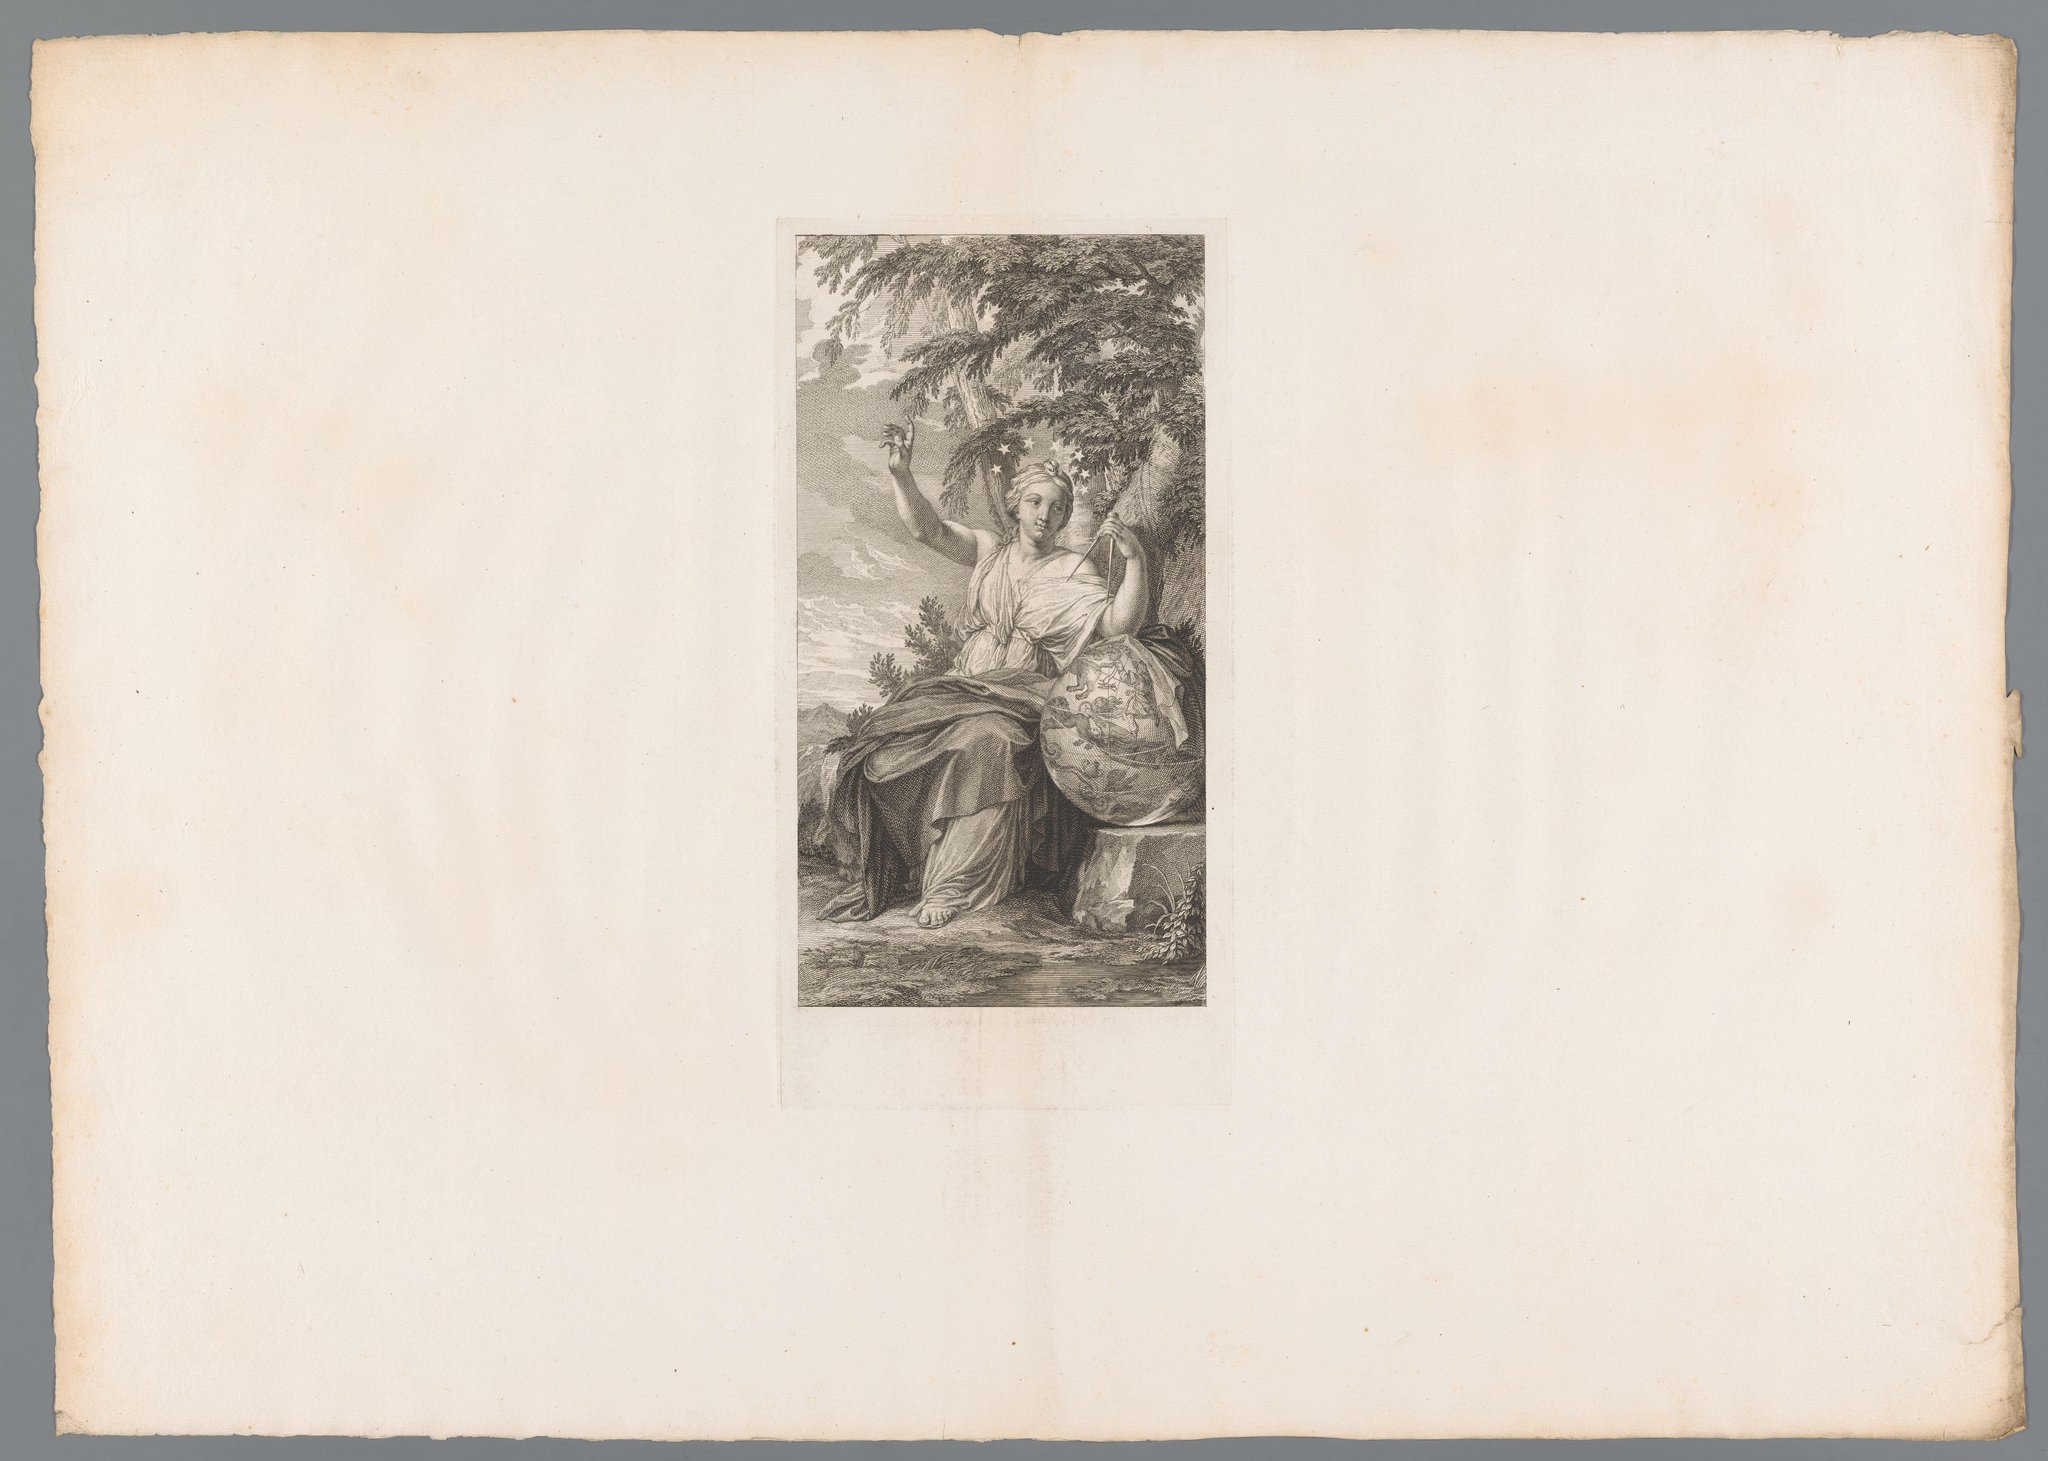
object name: print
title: Les peintures de Charles le Brun et d'Eustache Le Sueur qui sont dans (...) la maison du Président Lambert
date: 1740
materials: paper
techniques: engraving, etching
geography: paris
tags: urania (one of the muses); 'urania' (ripa)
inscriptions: collector's mark: Lugt 2228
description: Urania, de muze van de astronomie, zit onder een boom bij een globe met de sterrenbeelden en houdt een passer in de hand. Zij is gekroond met een kring van sterren. Naar het schilderij dat hing in de Chambre des Muses van het Hôtel Lambert. Prent maakt deel uit van een serie prenten naar de schilderijen in het Hôtel Lambert te Parijs.